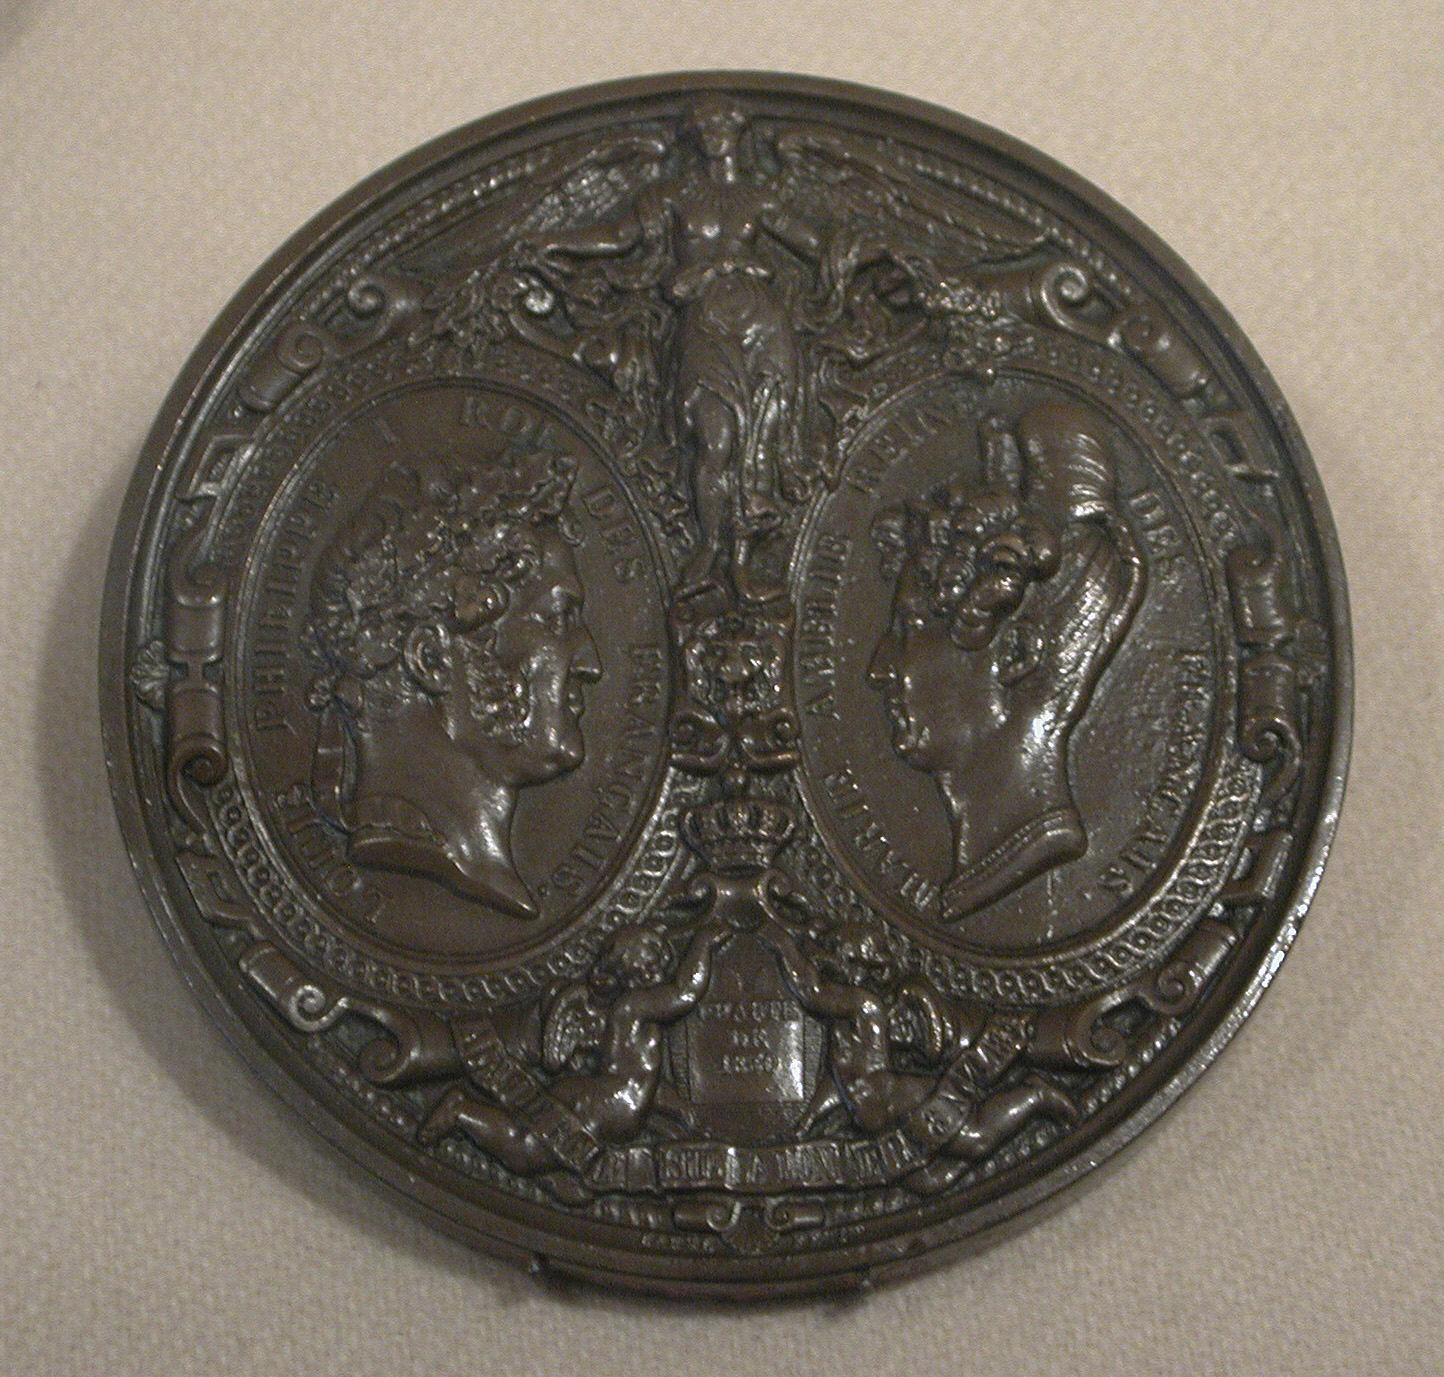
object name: medal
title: Commemorating the Visit of Louis-Philippe, Queen Marie Amélie, and the Royal Children to the Mint, November 8, 1833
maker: jean-jacques barre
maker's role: artist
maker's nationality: french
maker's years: 1793-1855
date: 1833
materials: bronze, patina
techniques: casting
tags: kings,queens,men,profiles,women